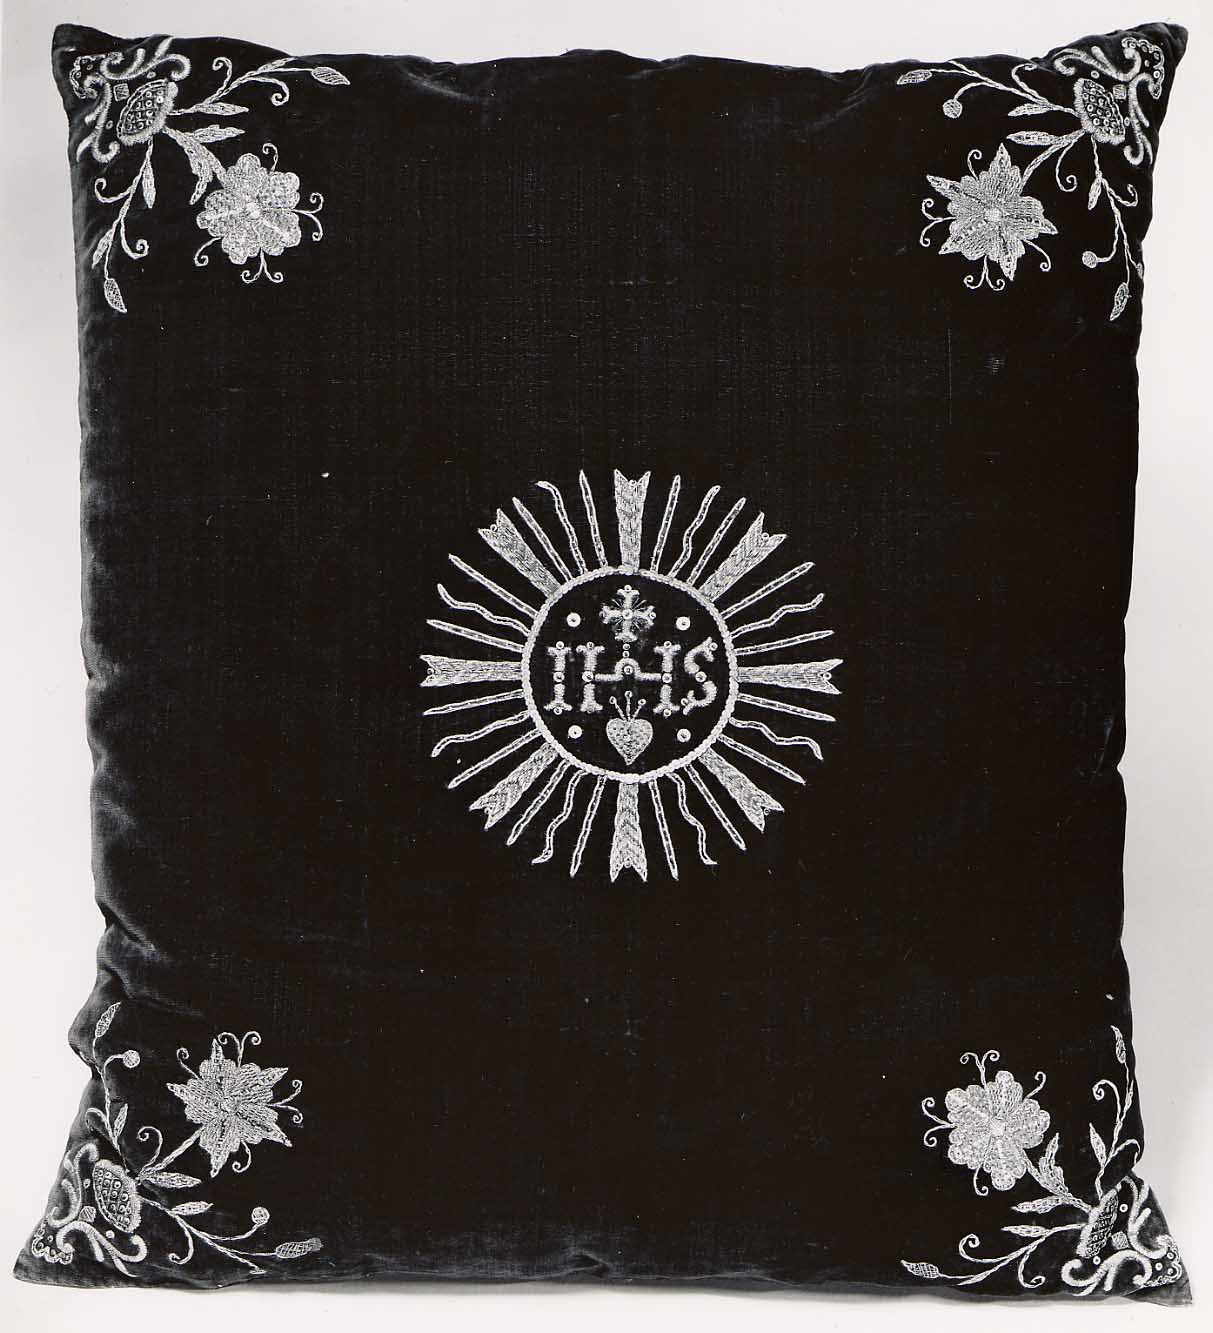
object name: pillow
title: Chalice Veil Made into a Cushion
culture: italian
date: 1701-1800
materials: metal, silk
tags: flowers